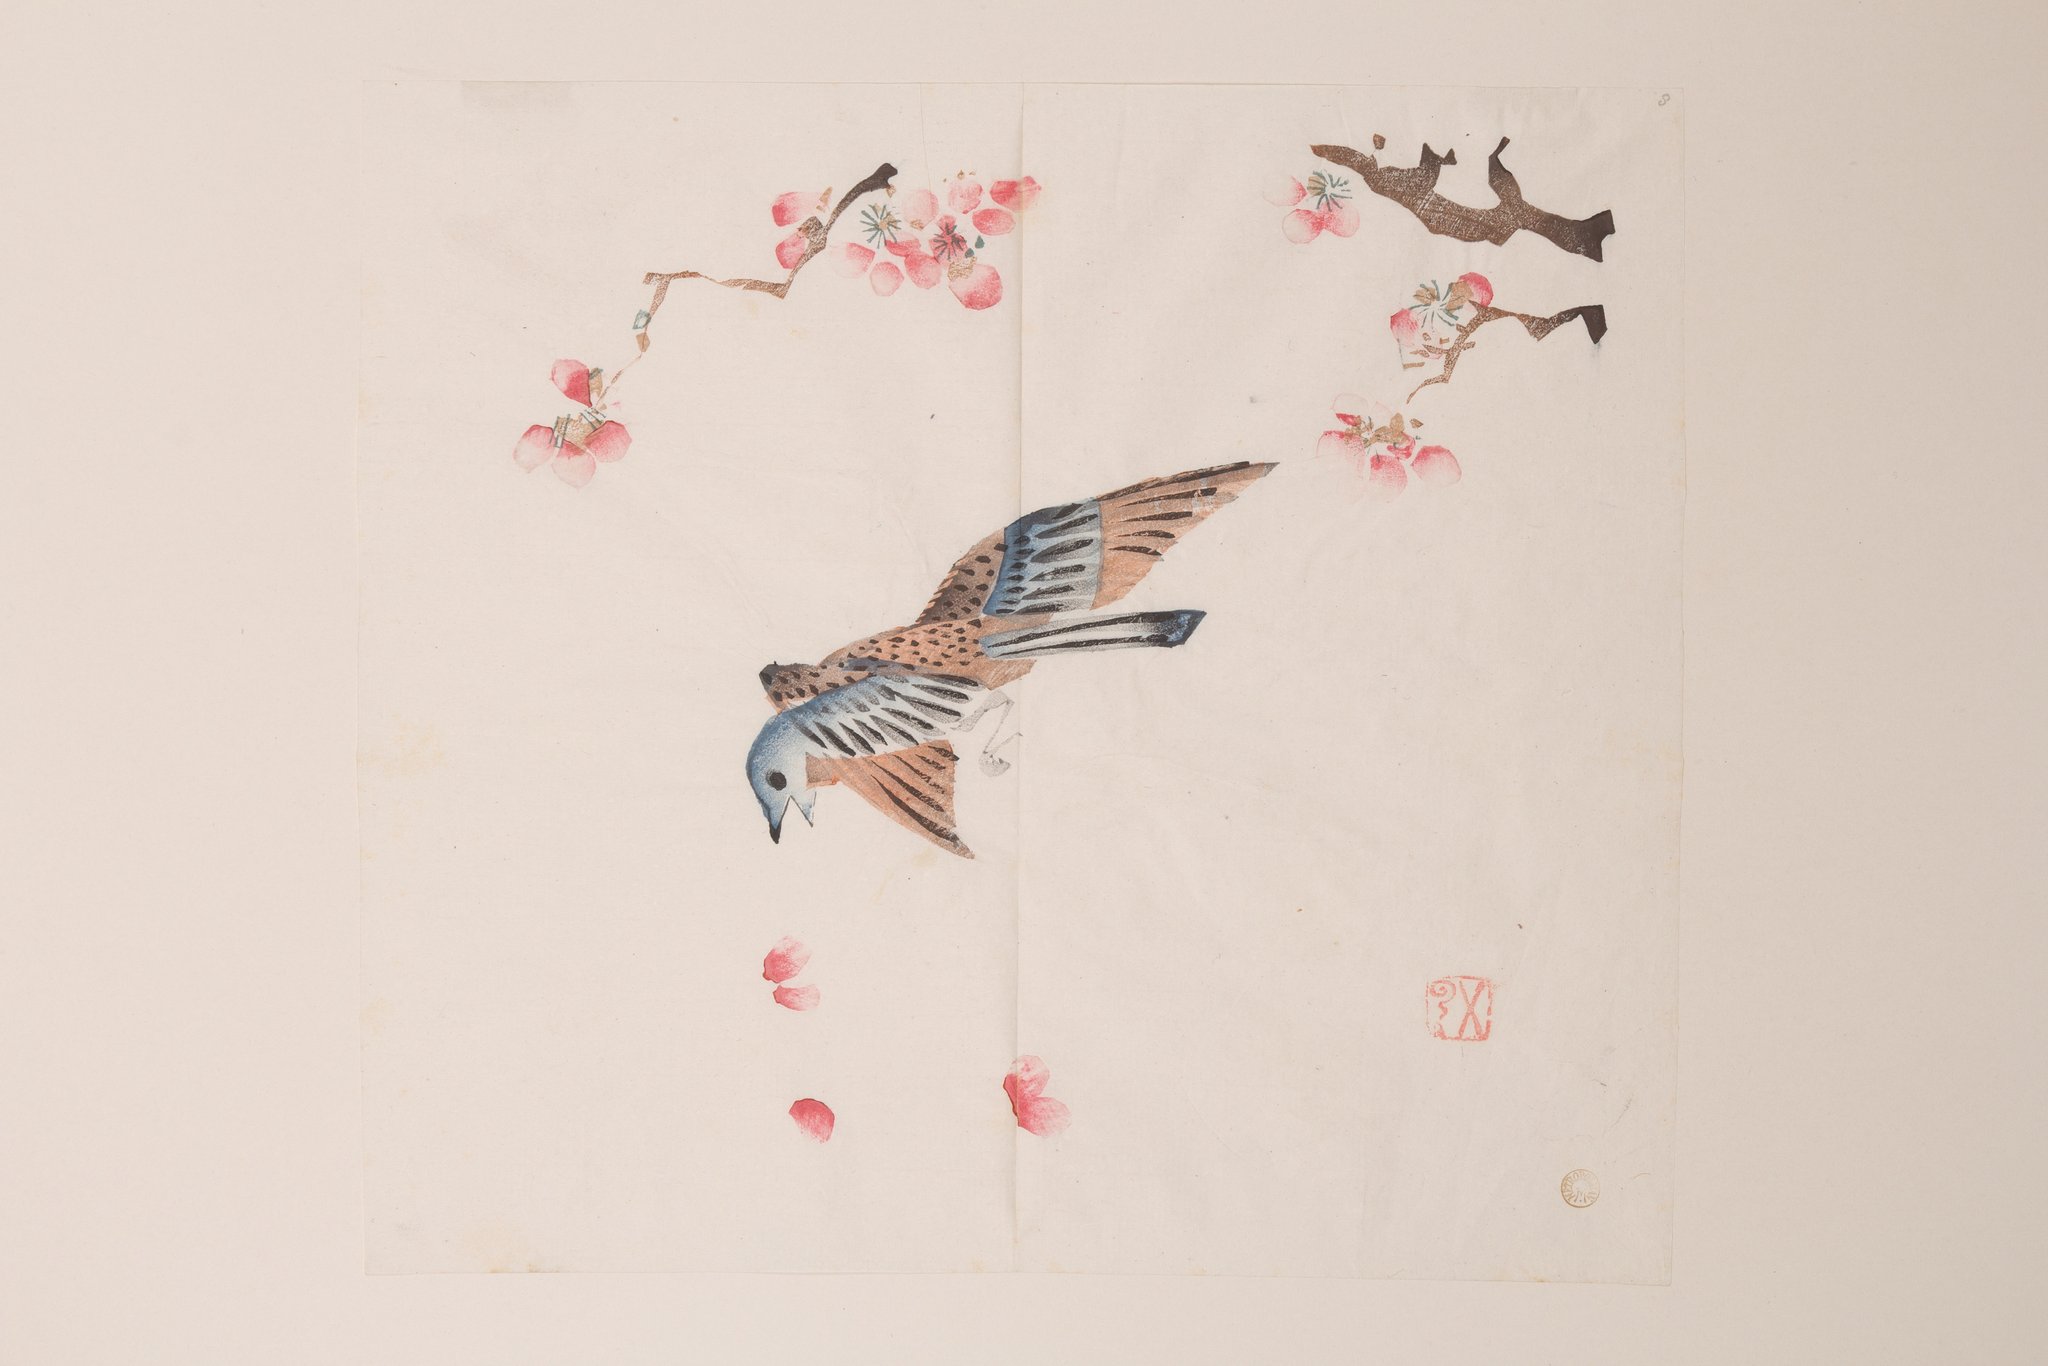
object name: print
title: Page from Shi Zhu Zhai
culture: chinese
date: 1736-1795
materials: ink, paper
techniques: polychrome, woodblock print